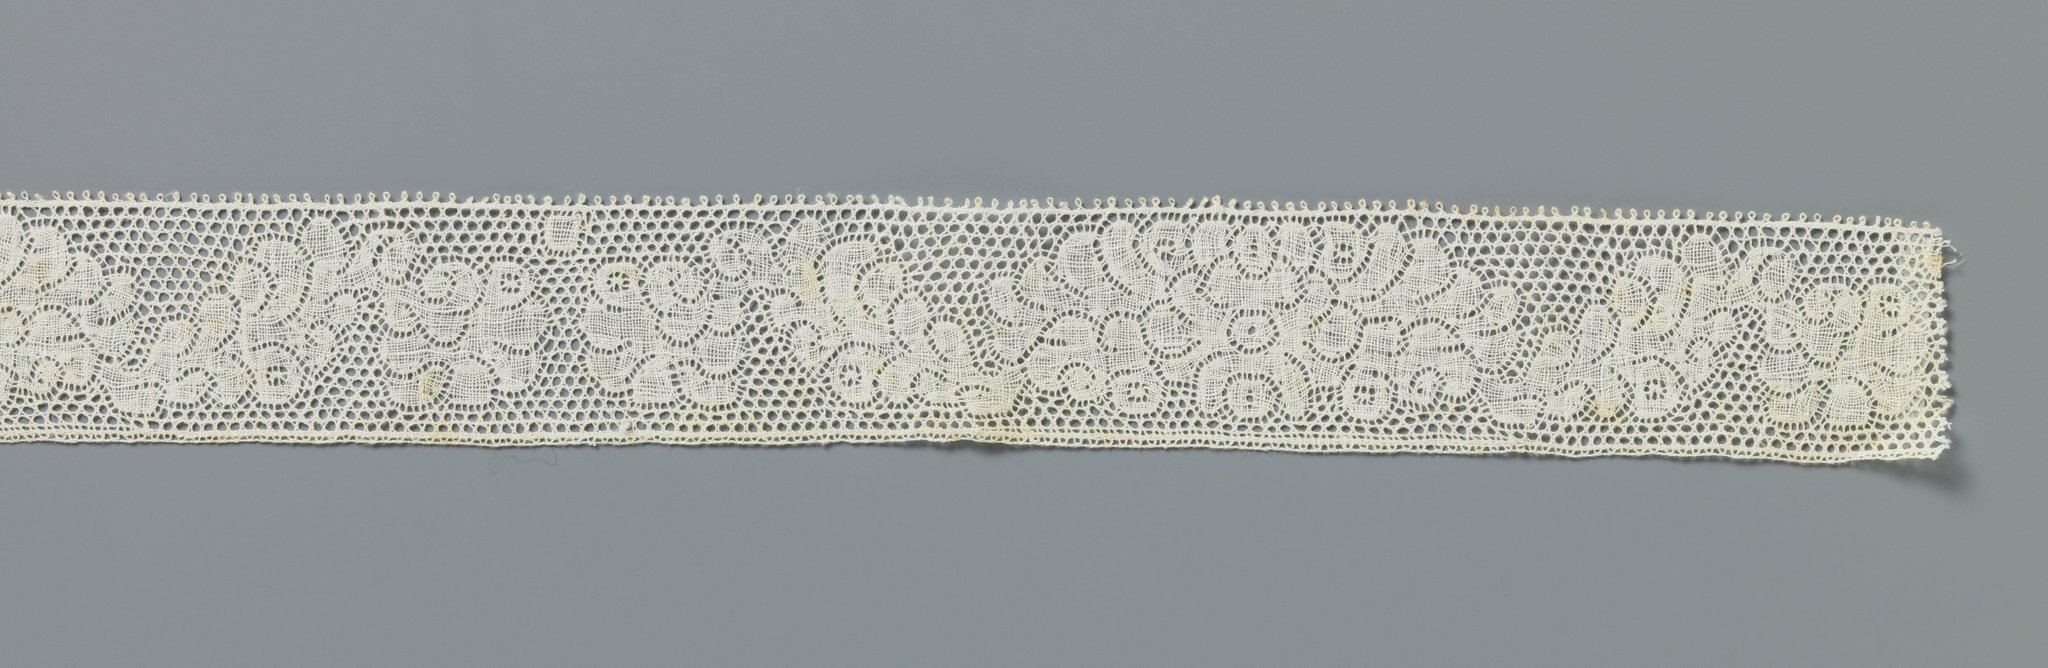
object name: strip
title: Strook kloskant met cirkeltje tussen ovaal pioenroos-motief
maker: Anonymous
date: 1900-1909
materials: cotton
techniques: lace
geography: flanders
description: Strook naturelkleurige Hollandse kloskant. Het zich herhalende en symmetrische patroon bestaat uit een gestileerde ovale pioenroos tussen twee kleinere en rondere pioenrozen, die met een s-vormig blad vanuit de zijkant van bloem ontspringen. Tussen de opeenvolgende pioenroos-motieven staat een los cirkeltje langs de onderzijde van de strook. De motieven zijn gemaakt in linnenslag met uitsparingen en opengewerkte randjes. In het linnenwerk komt een enkele losse sneeuwvlokken voor. De motieven zijn met elkaar verbonden door een traliegrond, een Parijse grond. De boven- en onderzijde zijn recht afgewerkt, met aan één zijde picots.